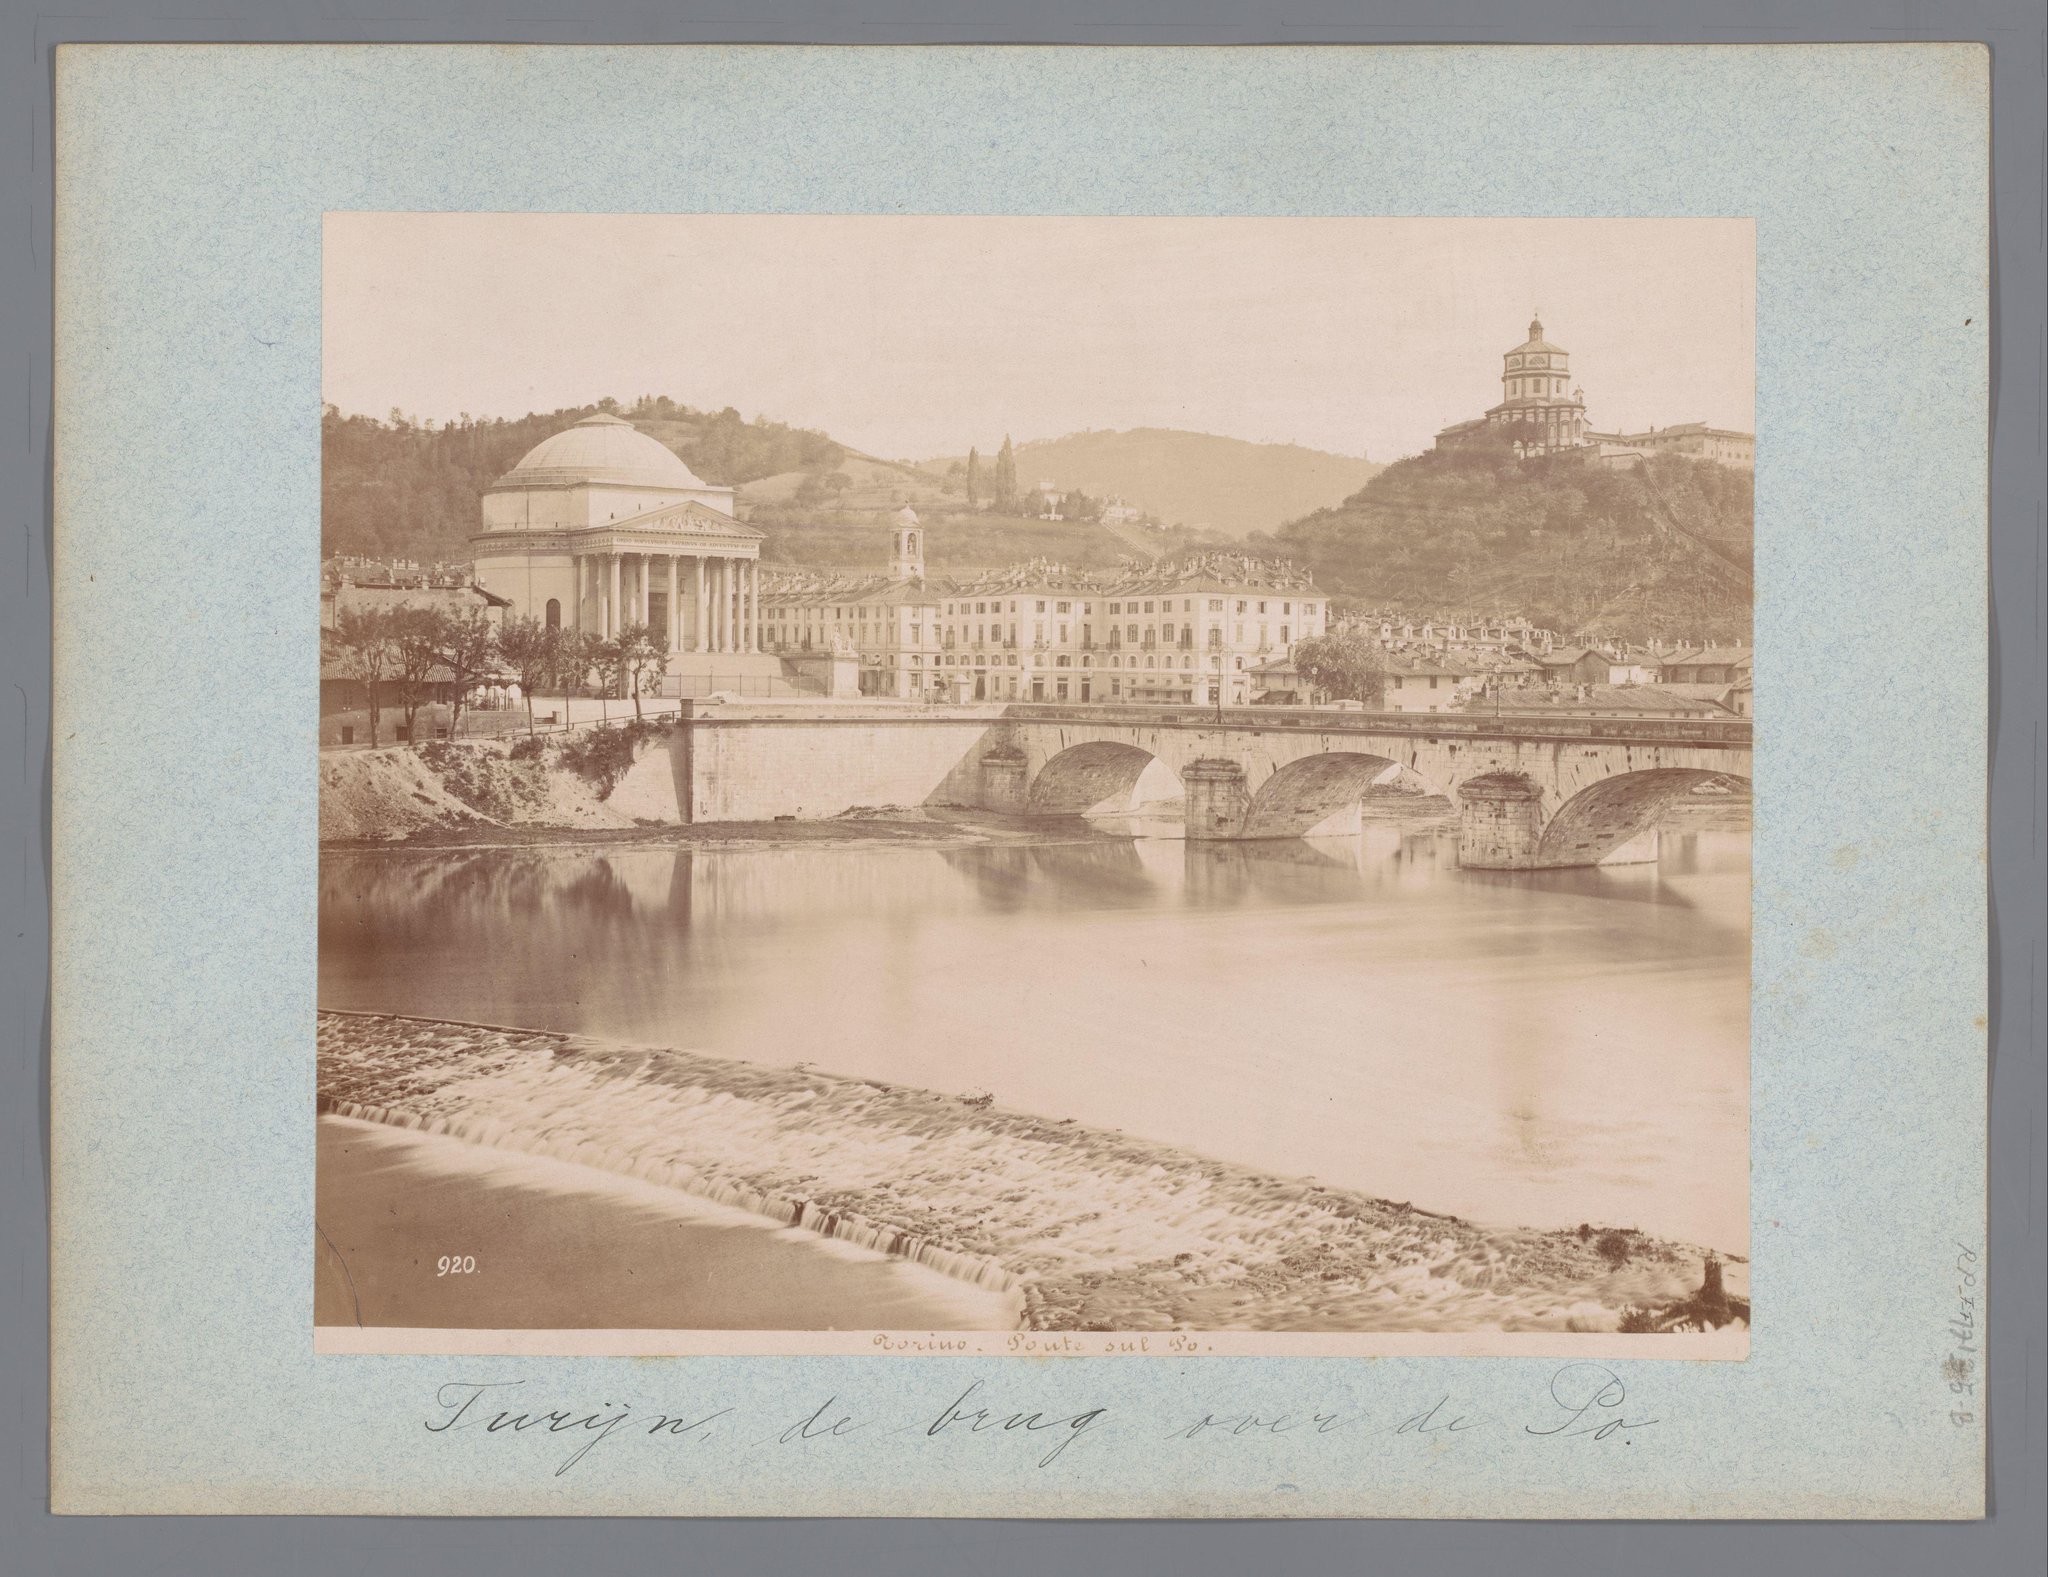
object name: photograph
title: Torino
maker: Anonymous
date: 1851-1900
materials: cardboard, paper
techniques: albumen print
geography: turin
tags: bridge in city across river, canal, etc.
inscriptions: number: ‘920.’, inscription: ‘Turijn, de brug over de Po.’